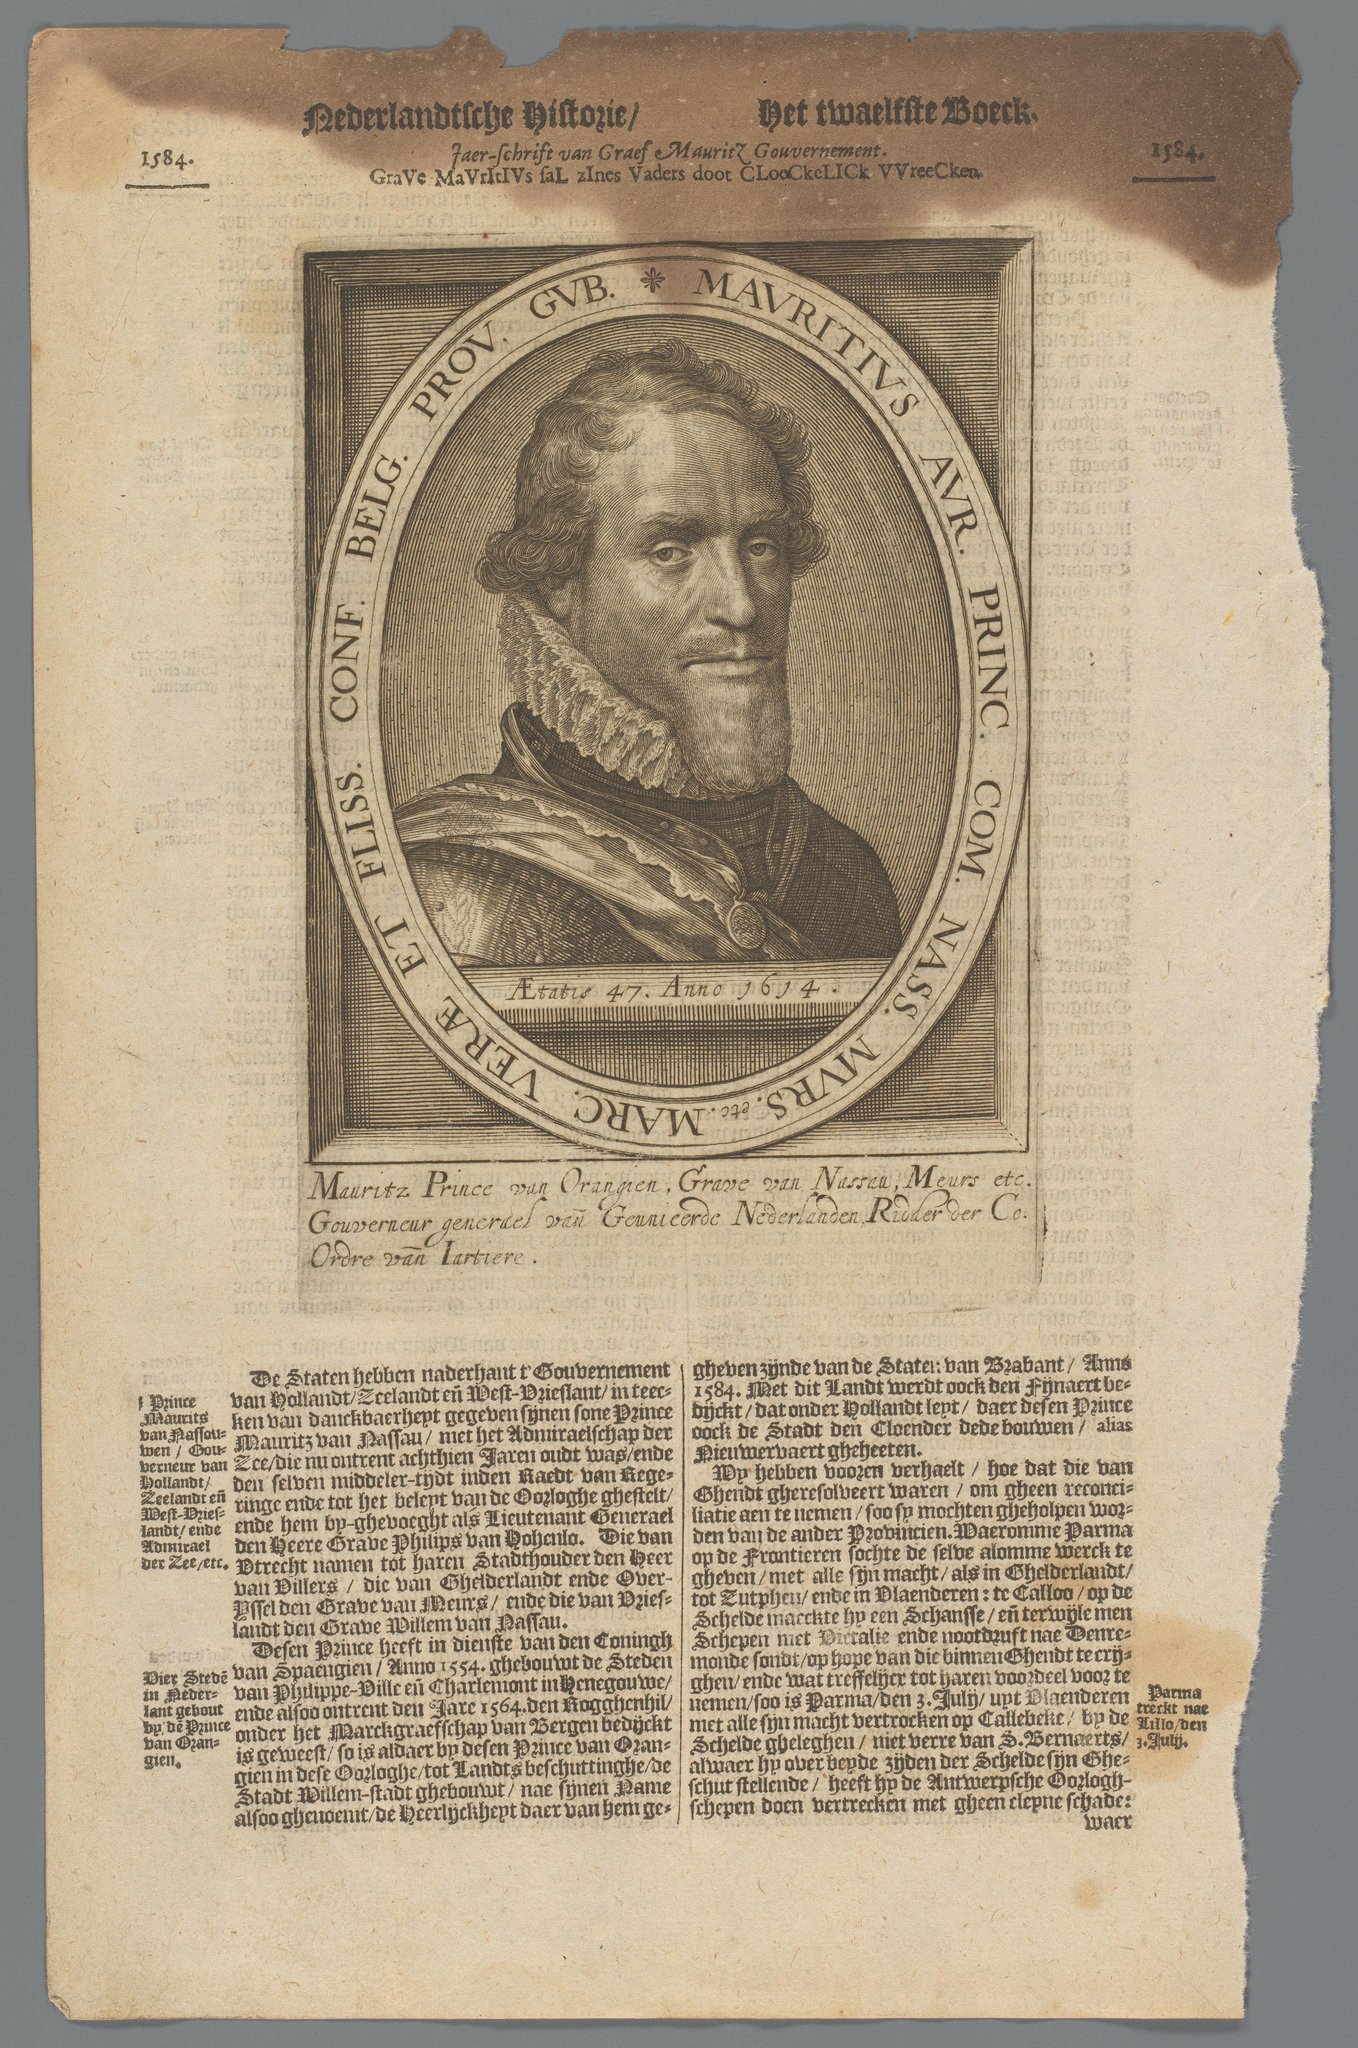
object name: print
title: Portret van Maurits, prins van Oranje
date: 1614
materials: paper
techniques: engraving, letterpress printing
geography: the hague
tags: the hague, maurice (prince of orange), historical persons, stadtholder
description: Prent uit: Meteren, Emanuel van. Historie der Nederlandscher ende haerder na-buren oorlogen ende geschiedenissen (...). Den Haag: Hillebrant Iacobsz. van Wouw, 1614.